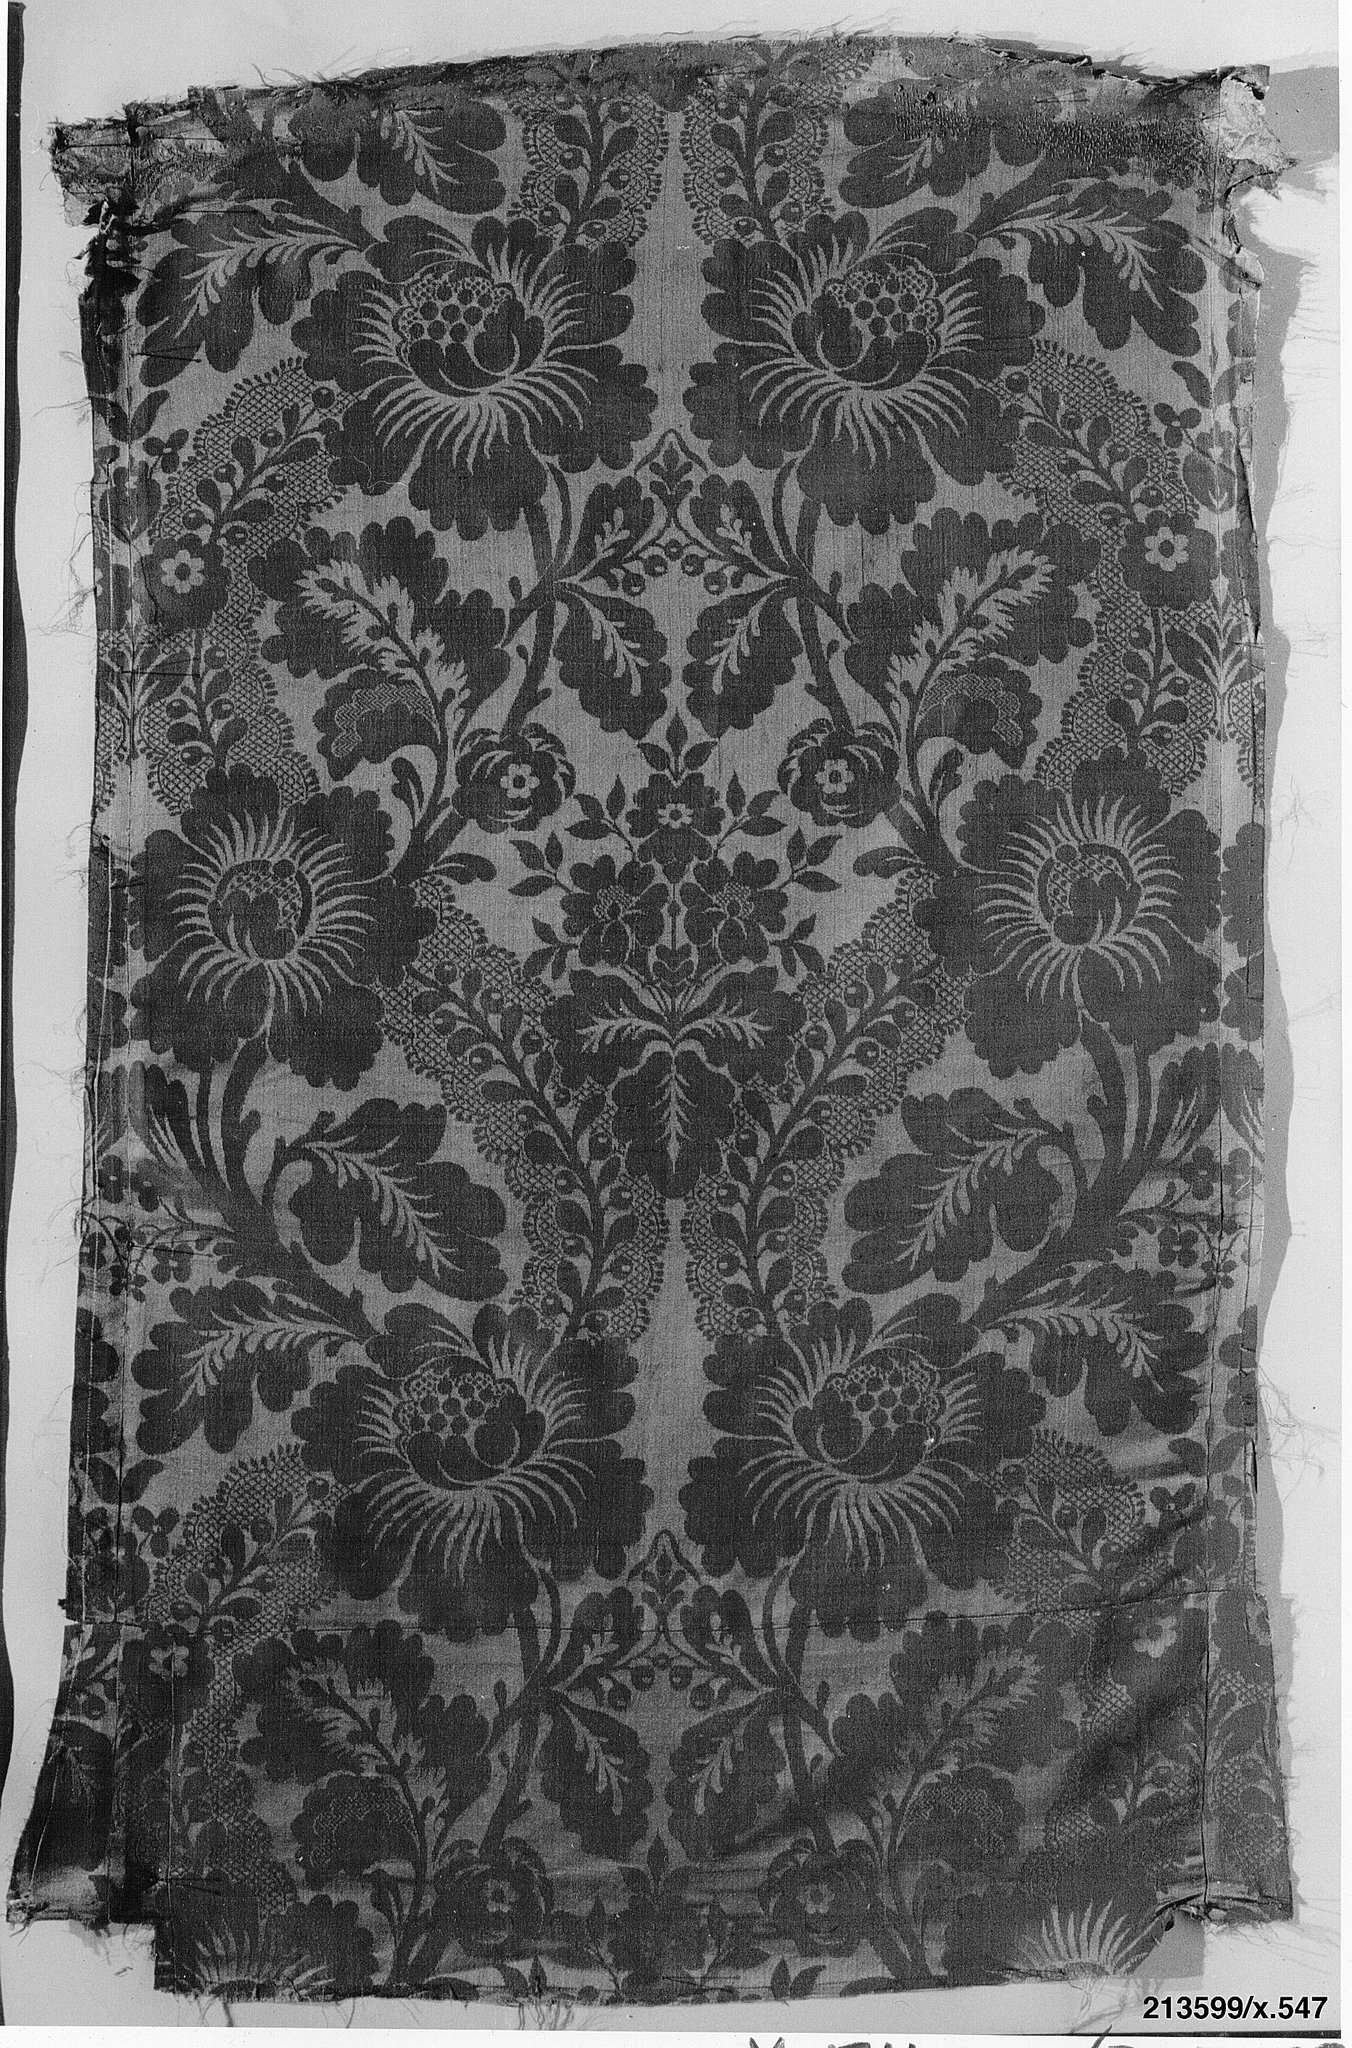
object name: piece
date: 1701-1800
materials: silk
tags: flowers,leaves